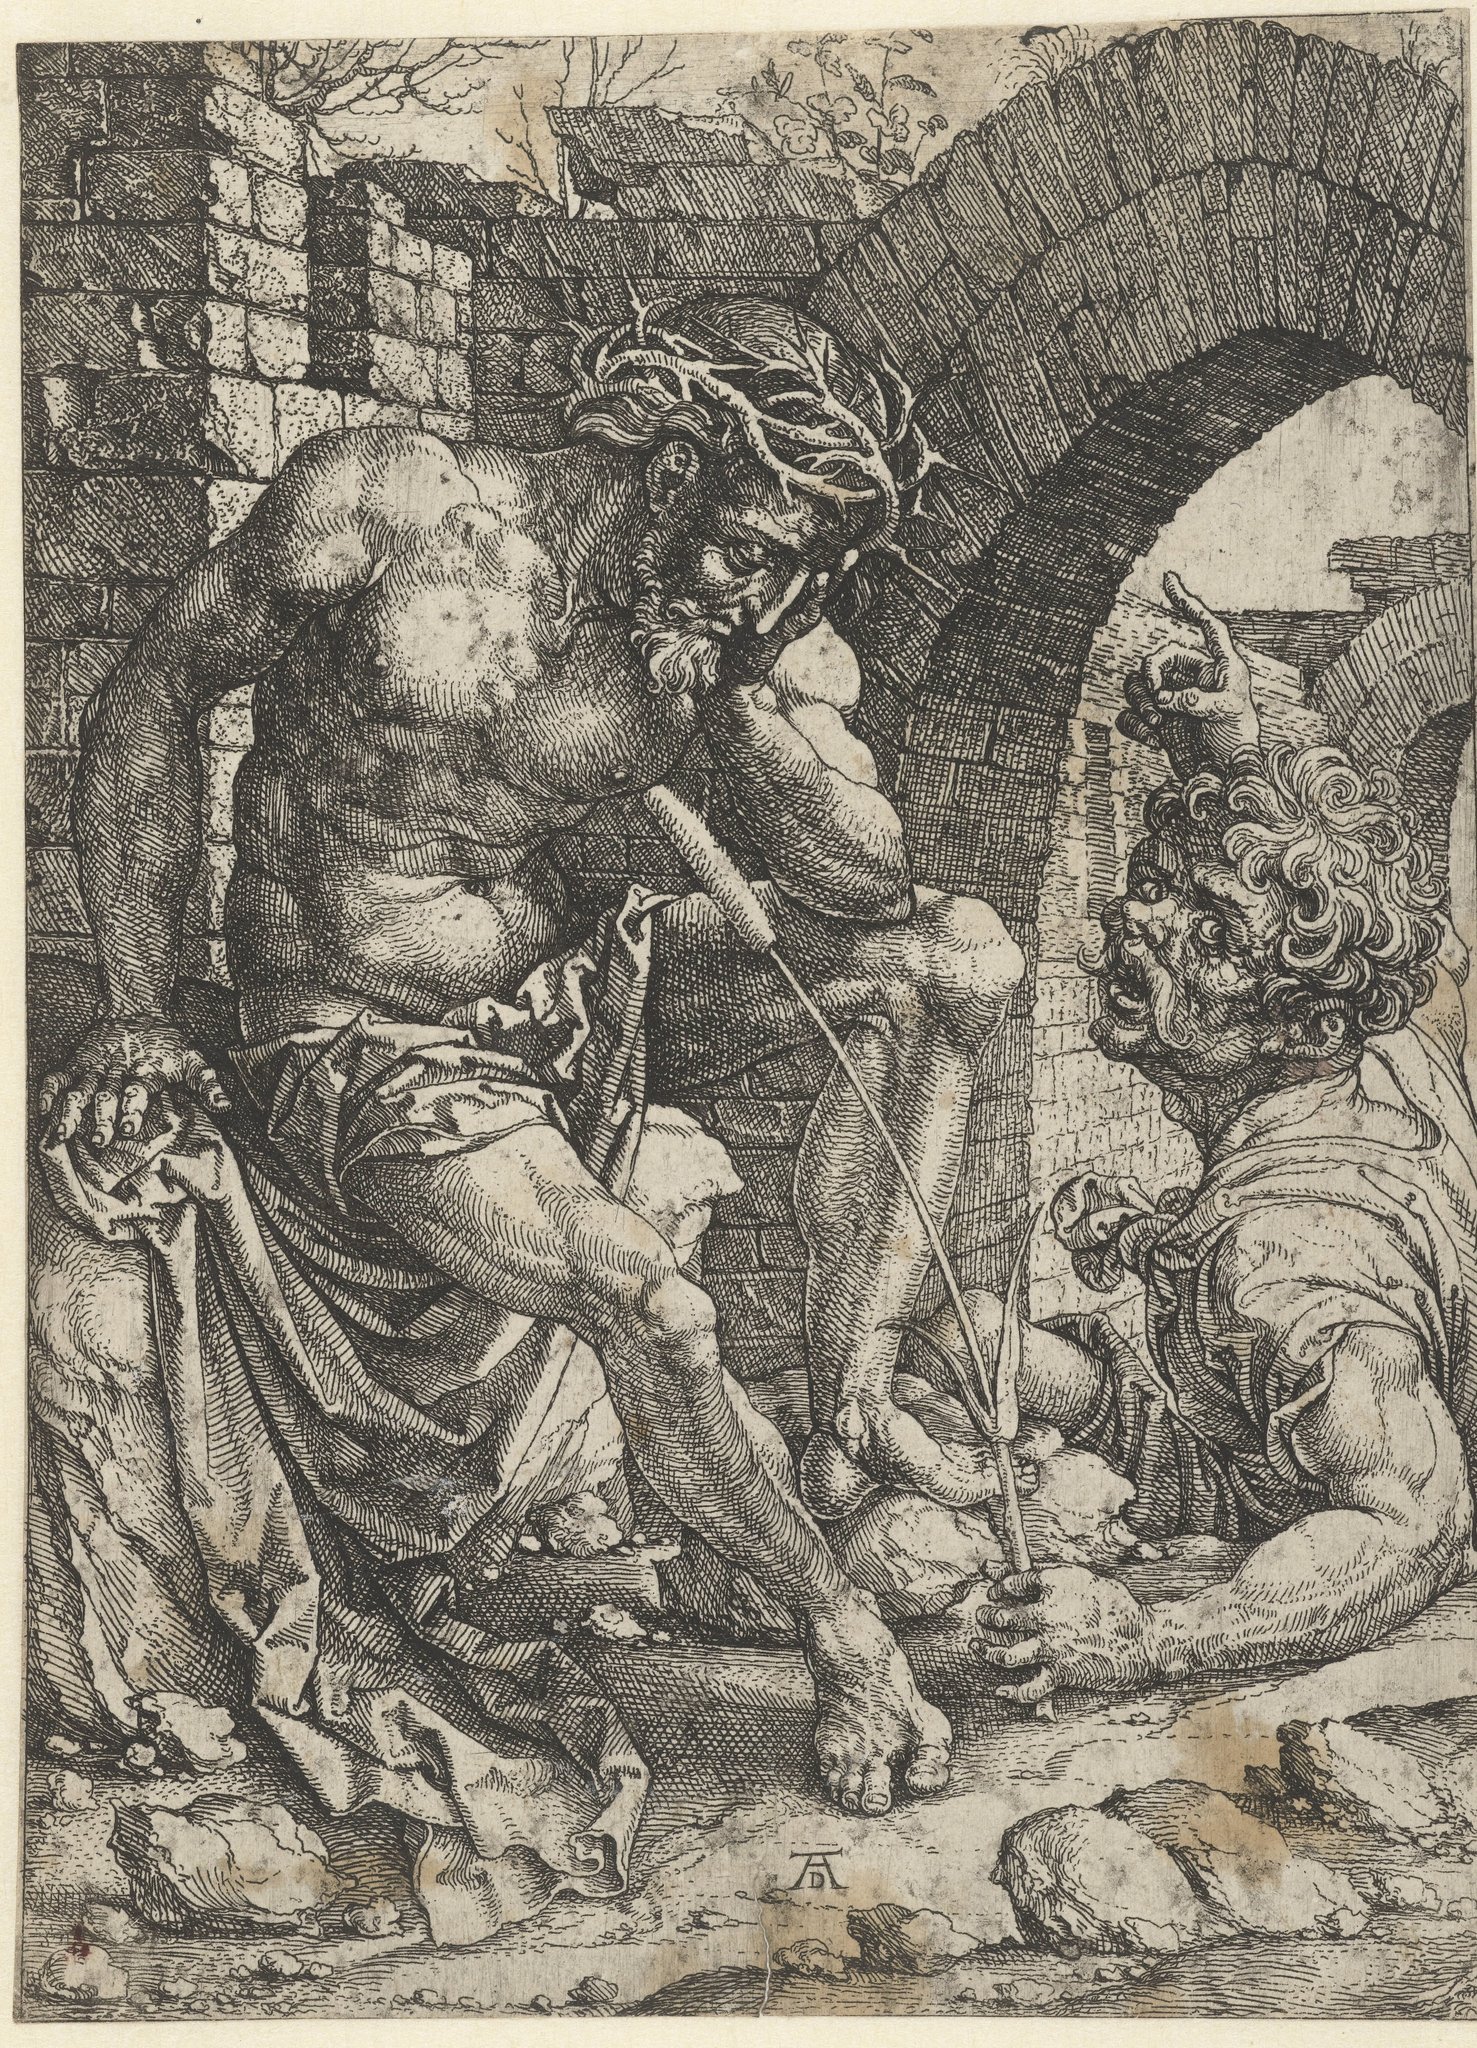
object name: print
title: Christus op de koude steen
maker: jan gossart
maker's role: draughtsman, painter, print maker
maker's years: 1478-1532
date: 1488-1535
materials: paper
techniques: etching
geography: low countries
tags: christ in agony waiting to be crucified; he is sitting on or near the cross or on a stone, 'christus im elend', 'christus in der rast'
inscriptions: collector's mark: Lugt 2228, inscription: ‘AD’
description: Christus met doornkroon zittend op steen. Man met lisdodde in linkerhand, liggend op grond, wijst omhoog.